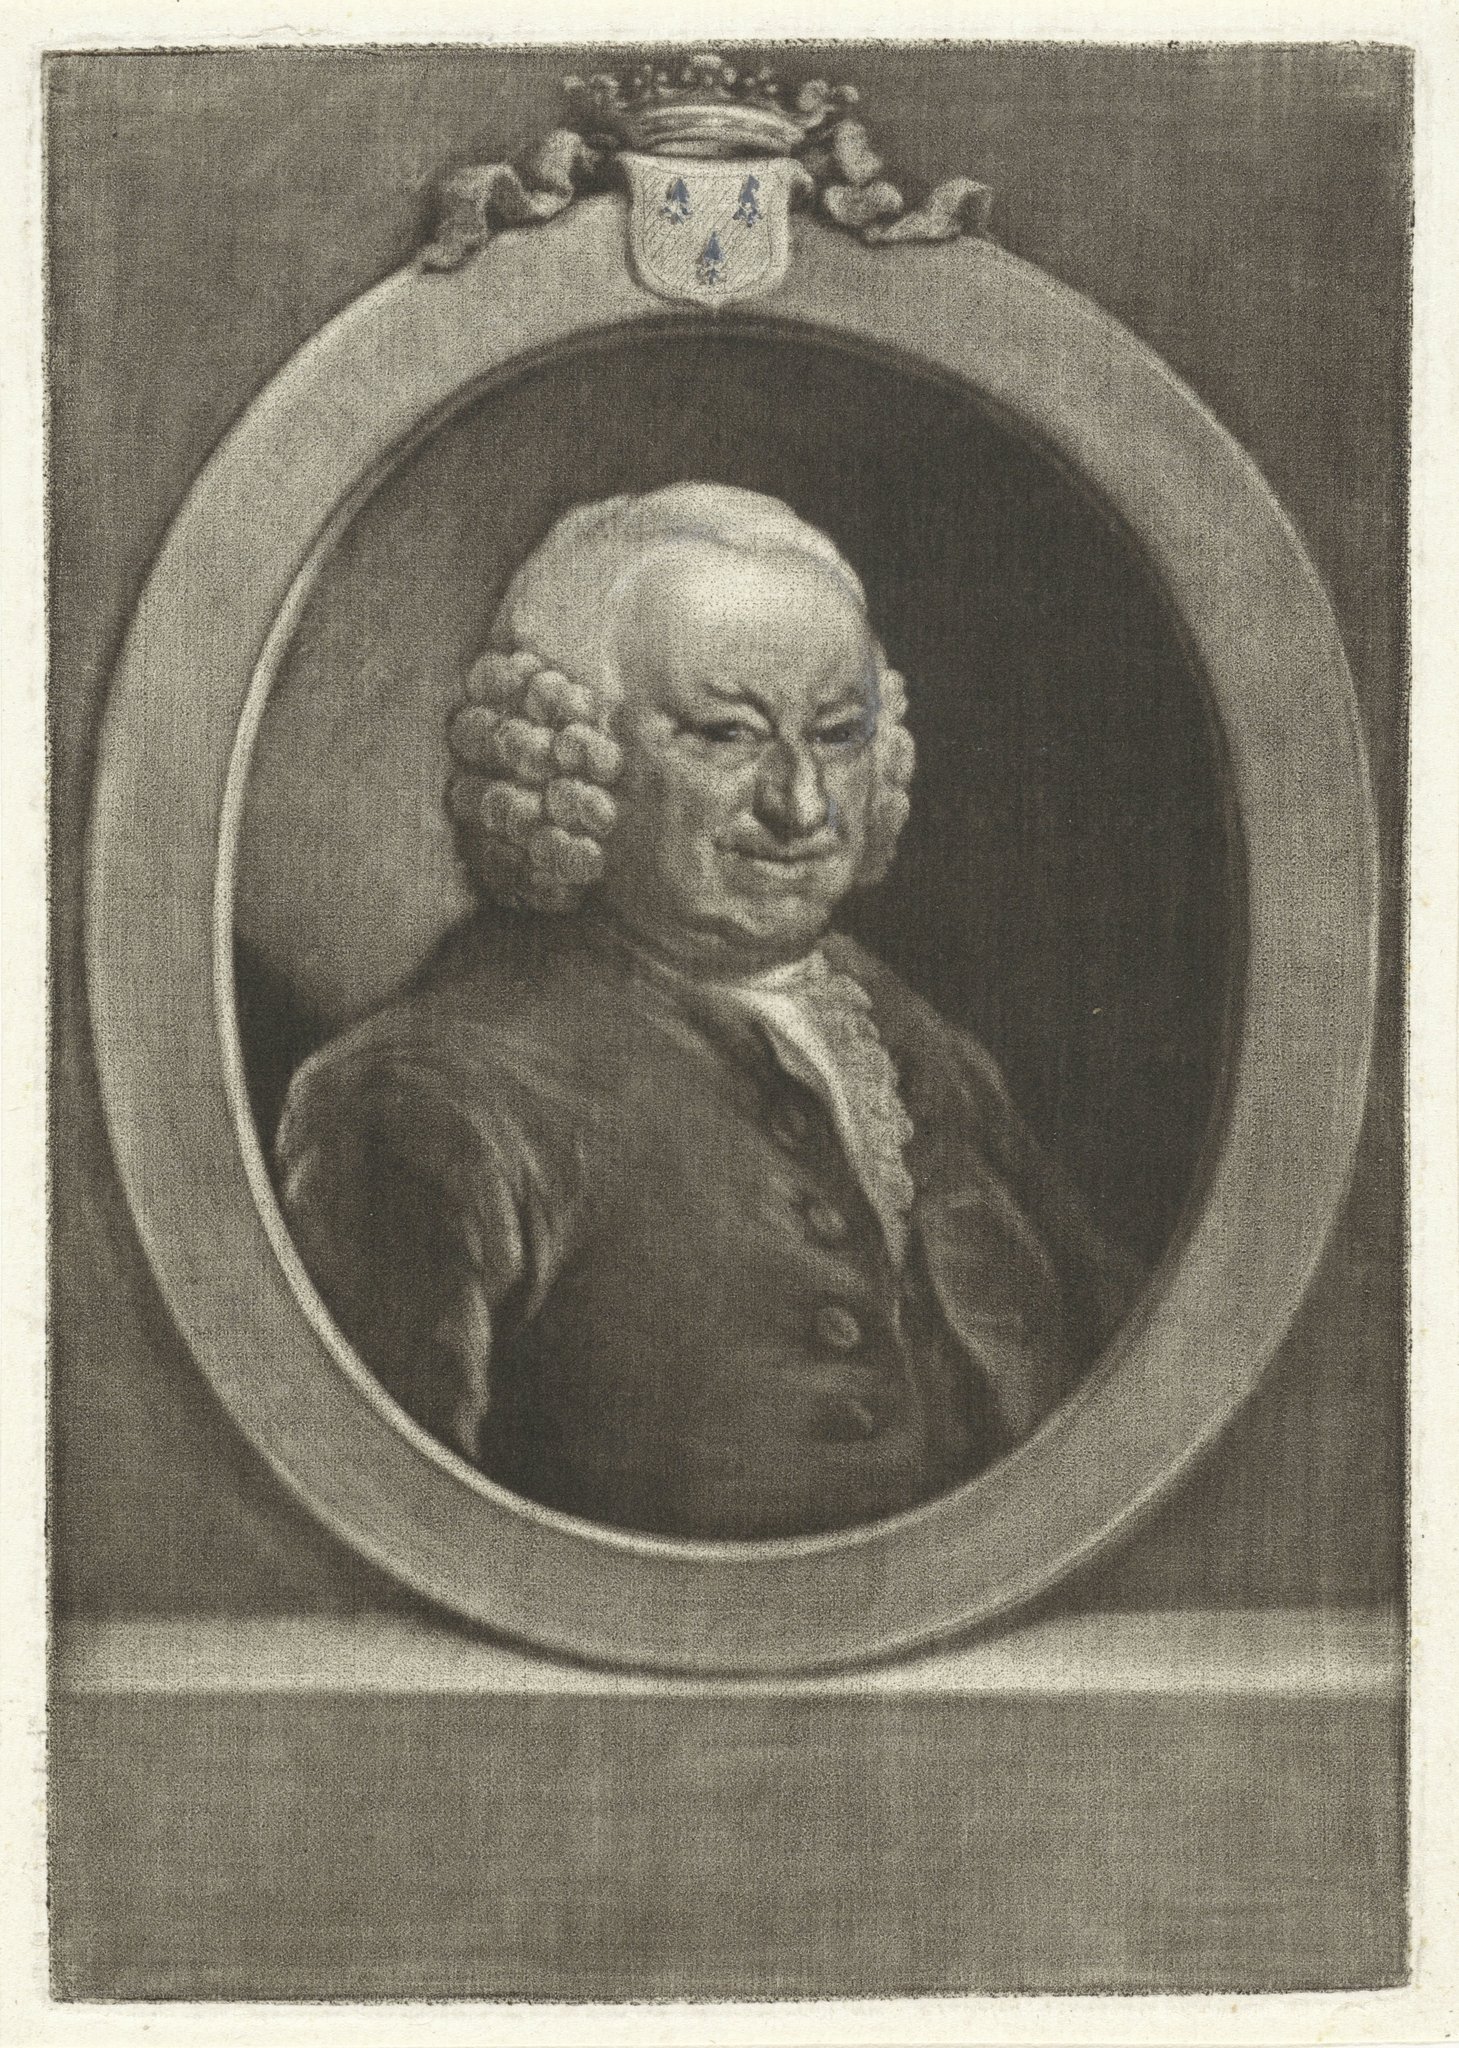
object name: print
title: Portret van Johan Hudde Dedel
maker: aert schouman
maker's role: draughtsman, painter, print maker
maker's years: 1710-1792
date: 1778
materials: paper, pencil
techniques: mezzotint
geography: the hague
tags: amsterdam, mayor, armorial bearing, heraldry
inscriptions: collector's mark: Lugt 2228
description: Johan Hudde Dedel, burgemeester van Den Haag en dichter. Bovenaan de omlijsting een gekroond wapenschild.